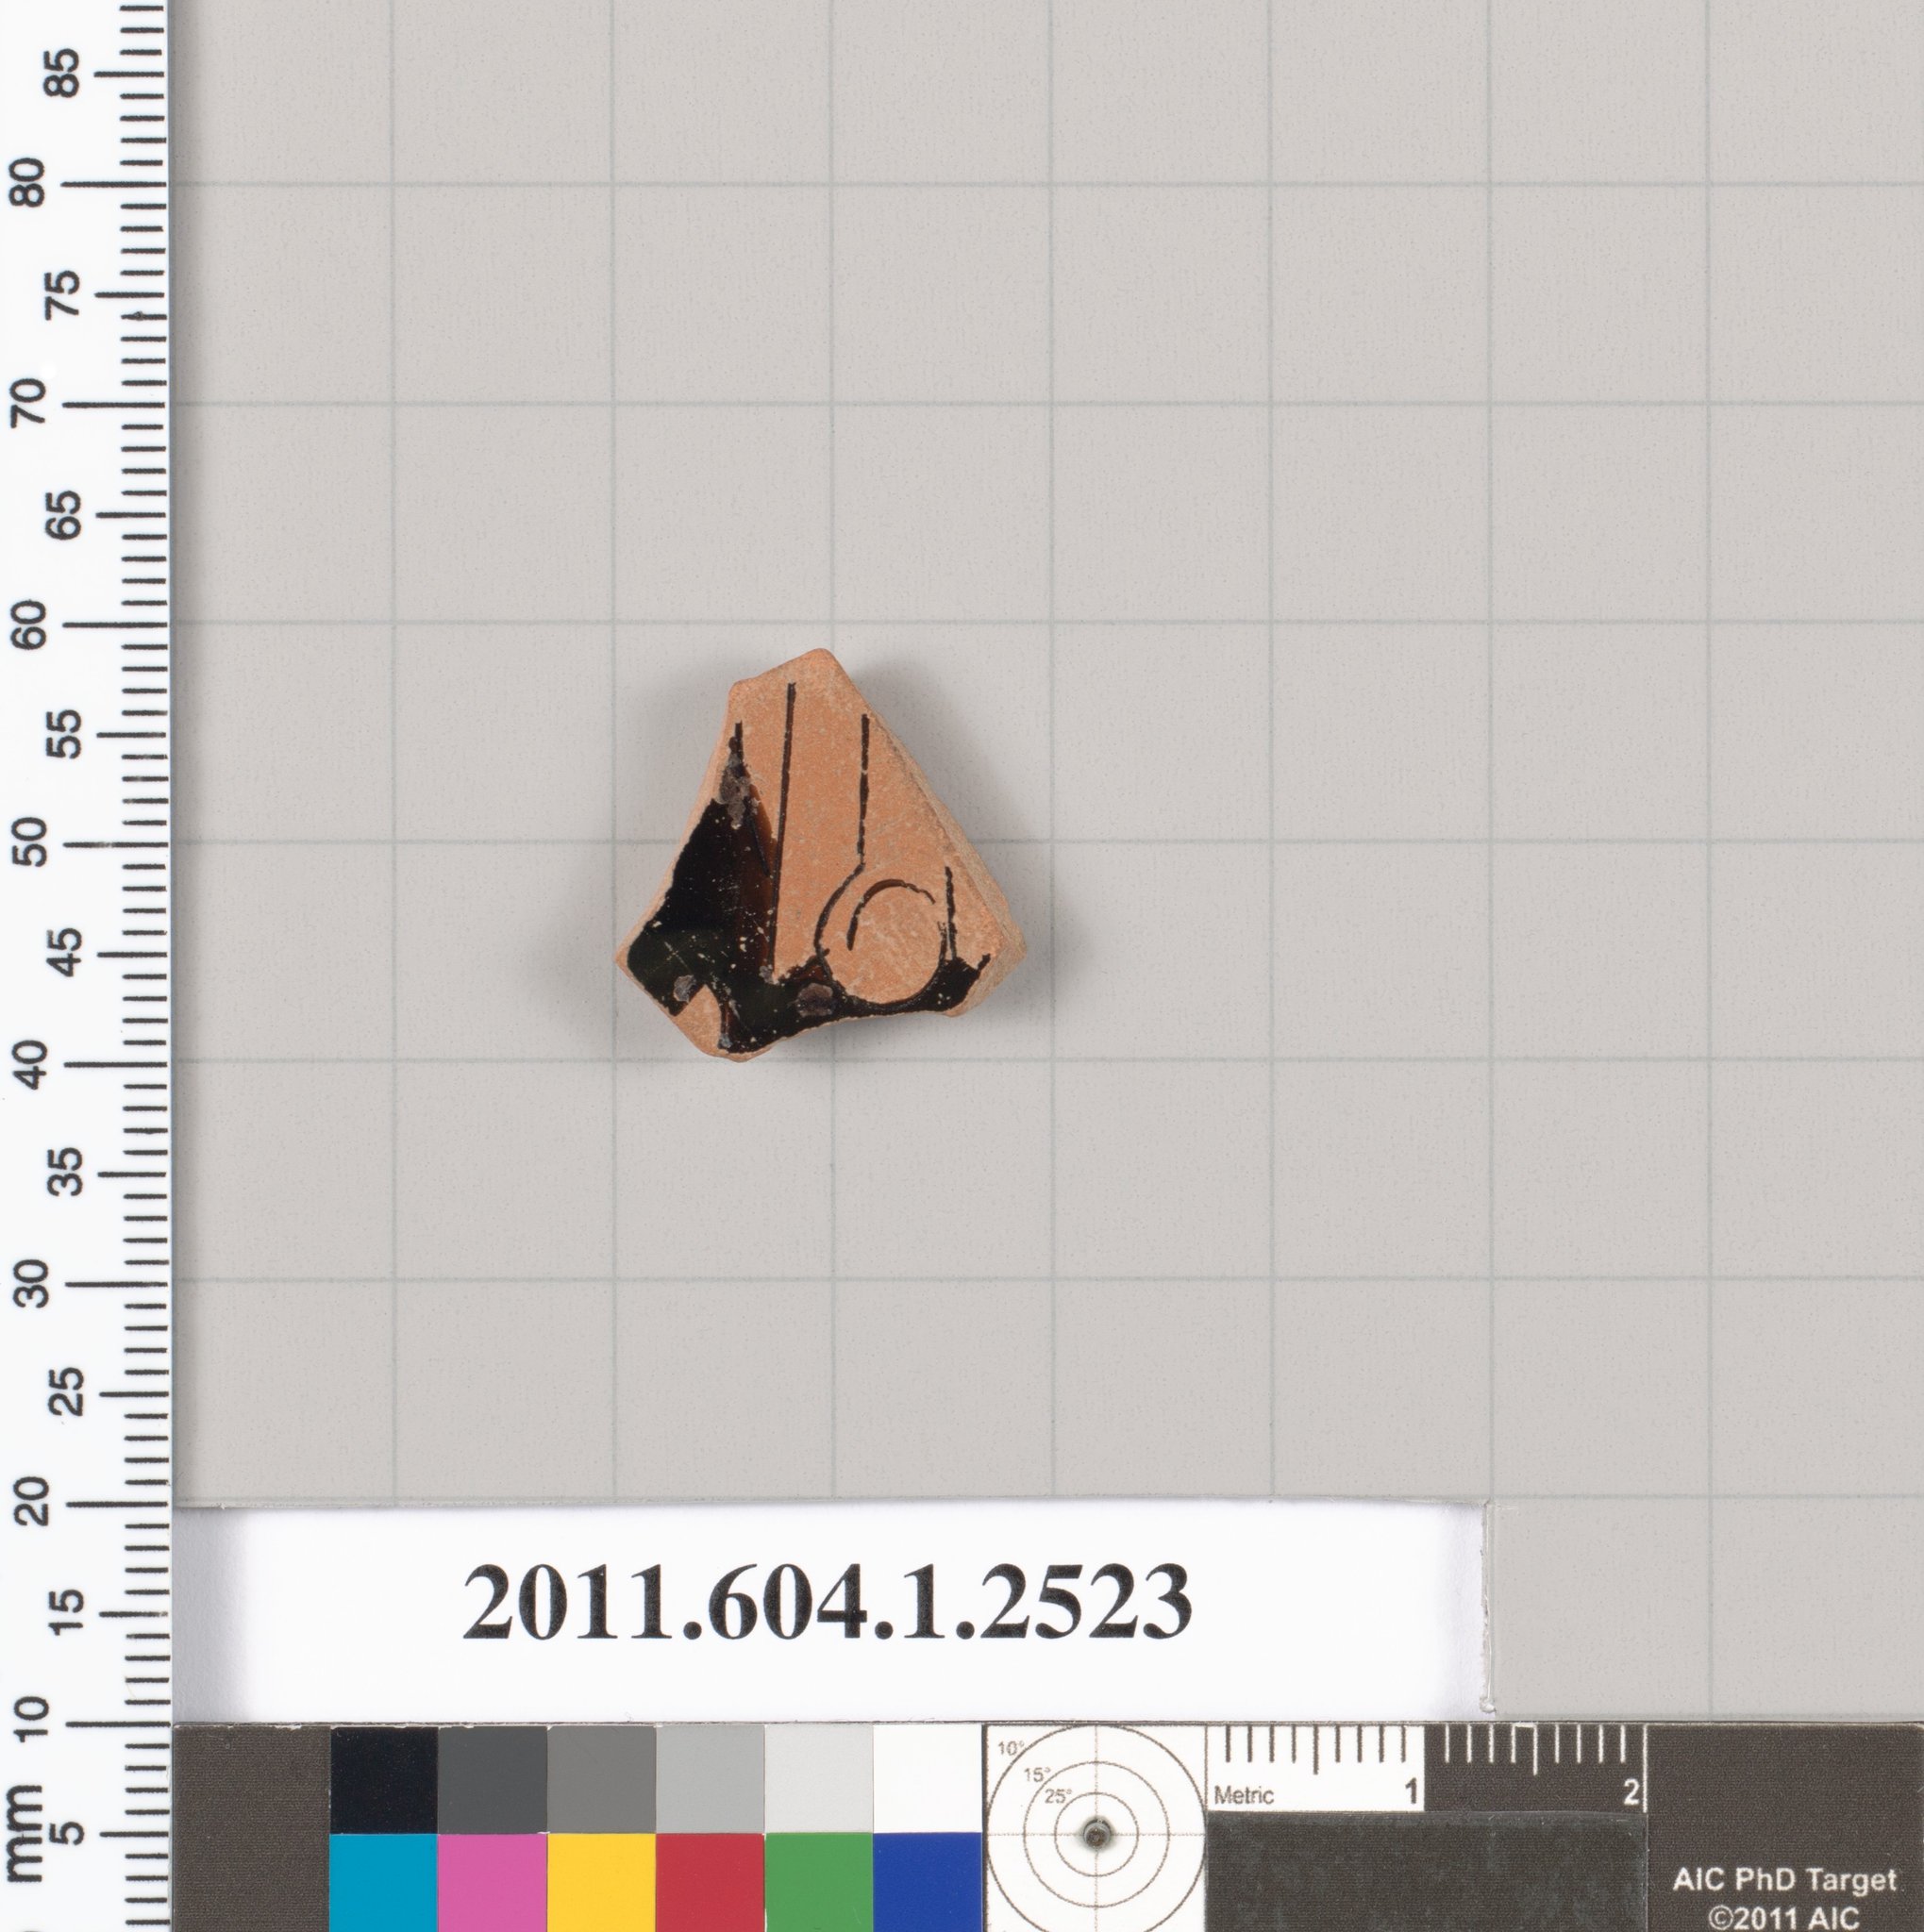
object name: kylix fragment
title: Terracotta fragment of a kylix (drinking cup)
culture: greek, attic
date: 490-480 BCE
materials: terracotta